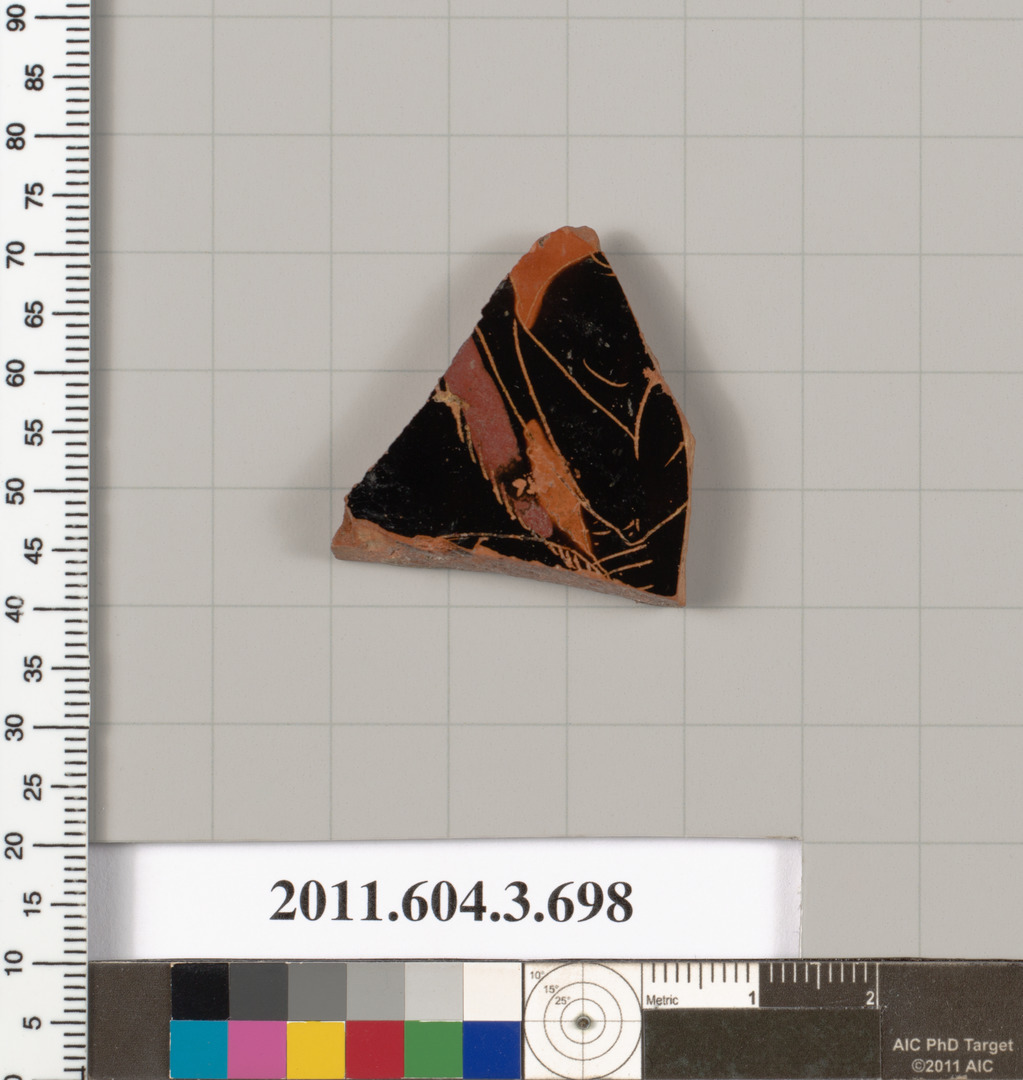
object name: hydria fragment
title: Terracotta fragment of a hydria (water jar)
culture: greek, attic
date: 525-501 BCE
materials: terracotta